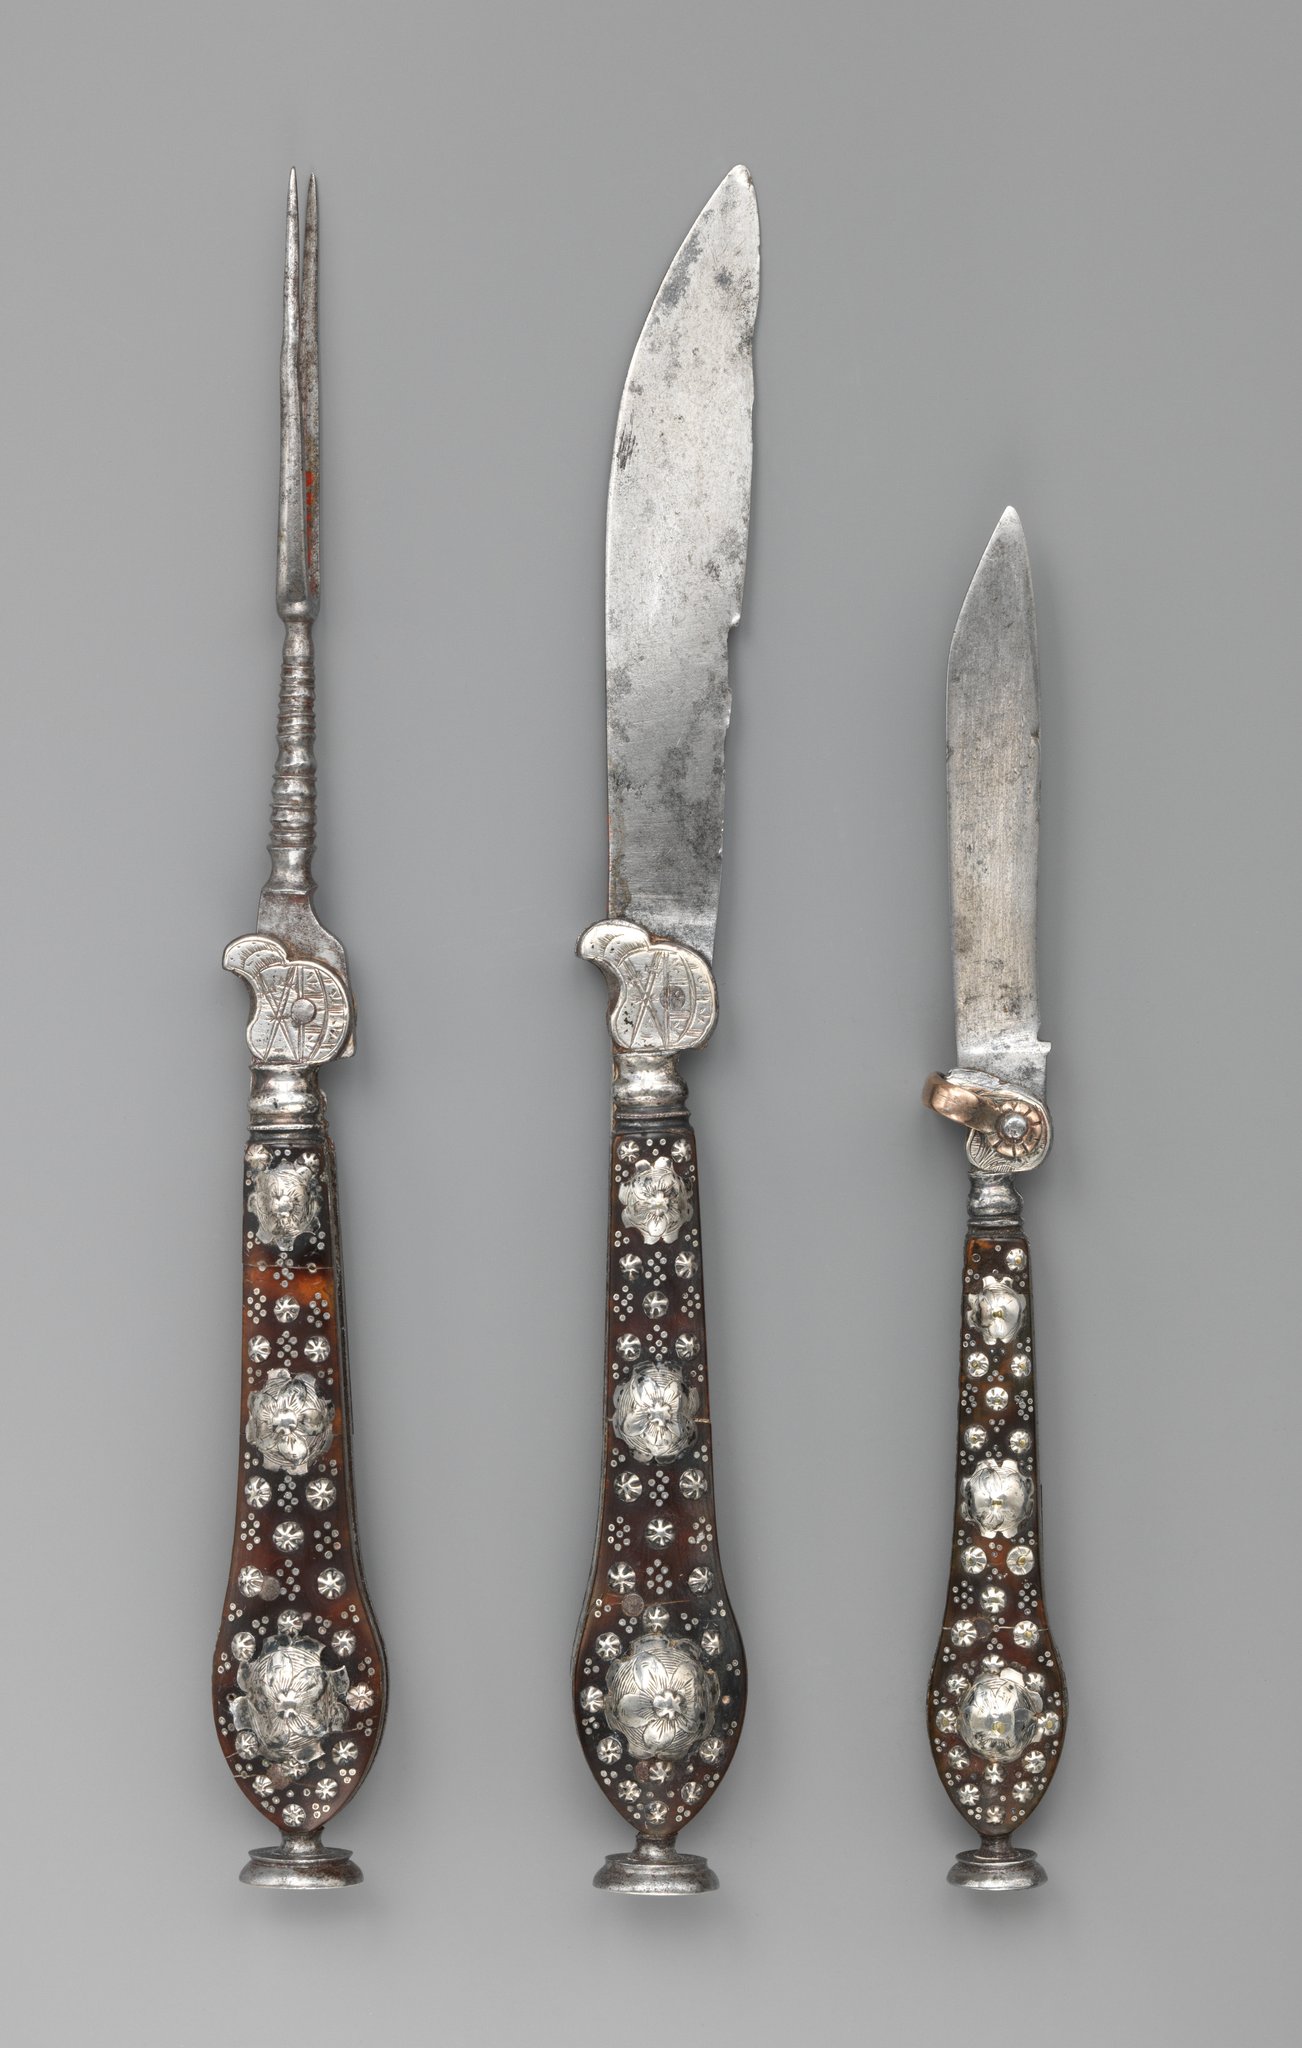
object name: knife, fork, and pen knife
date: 1601-1700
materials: silver, steel, shell